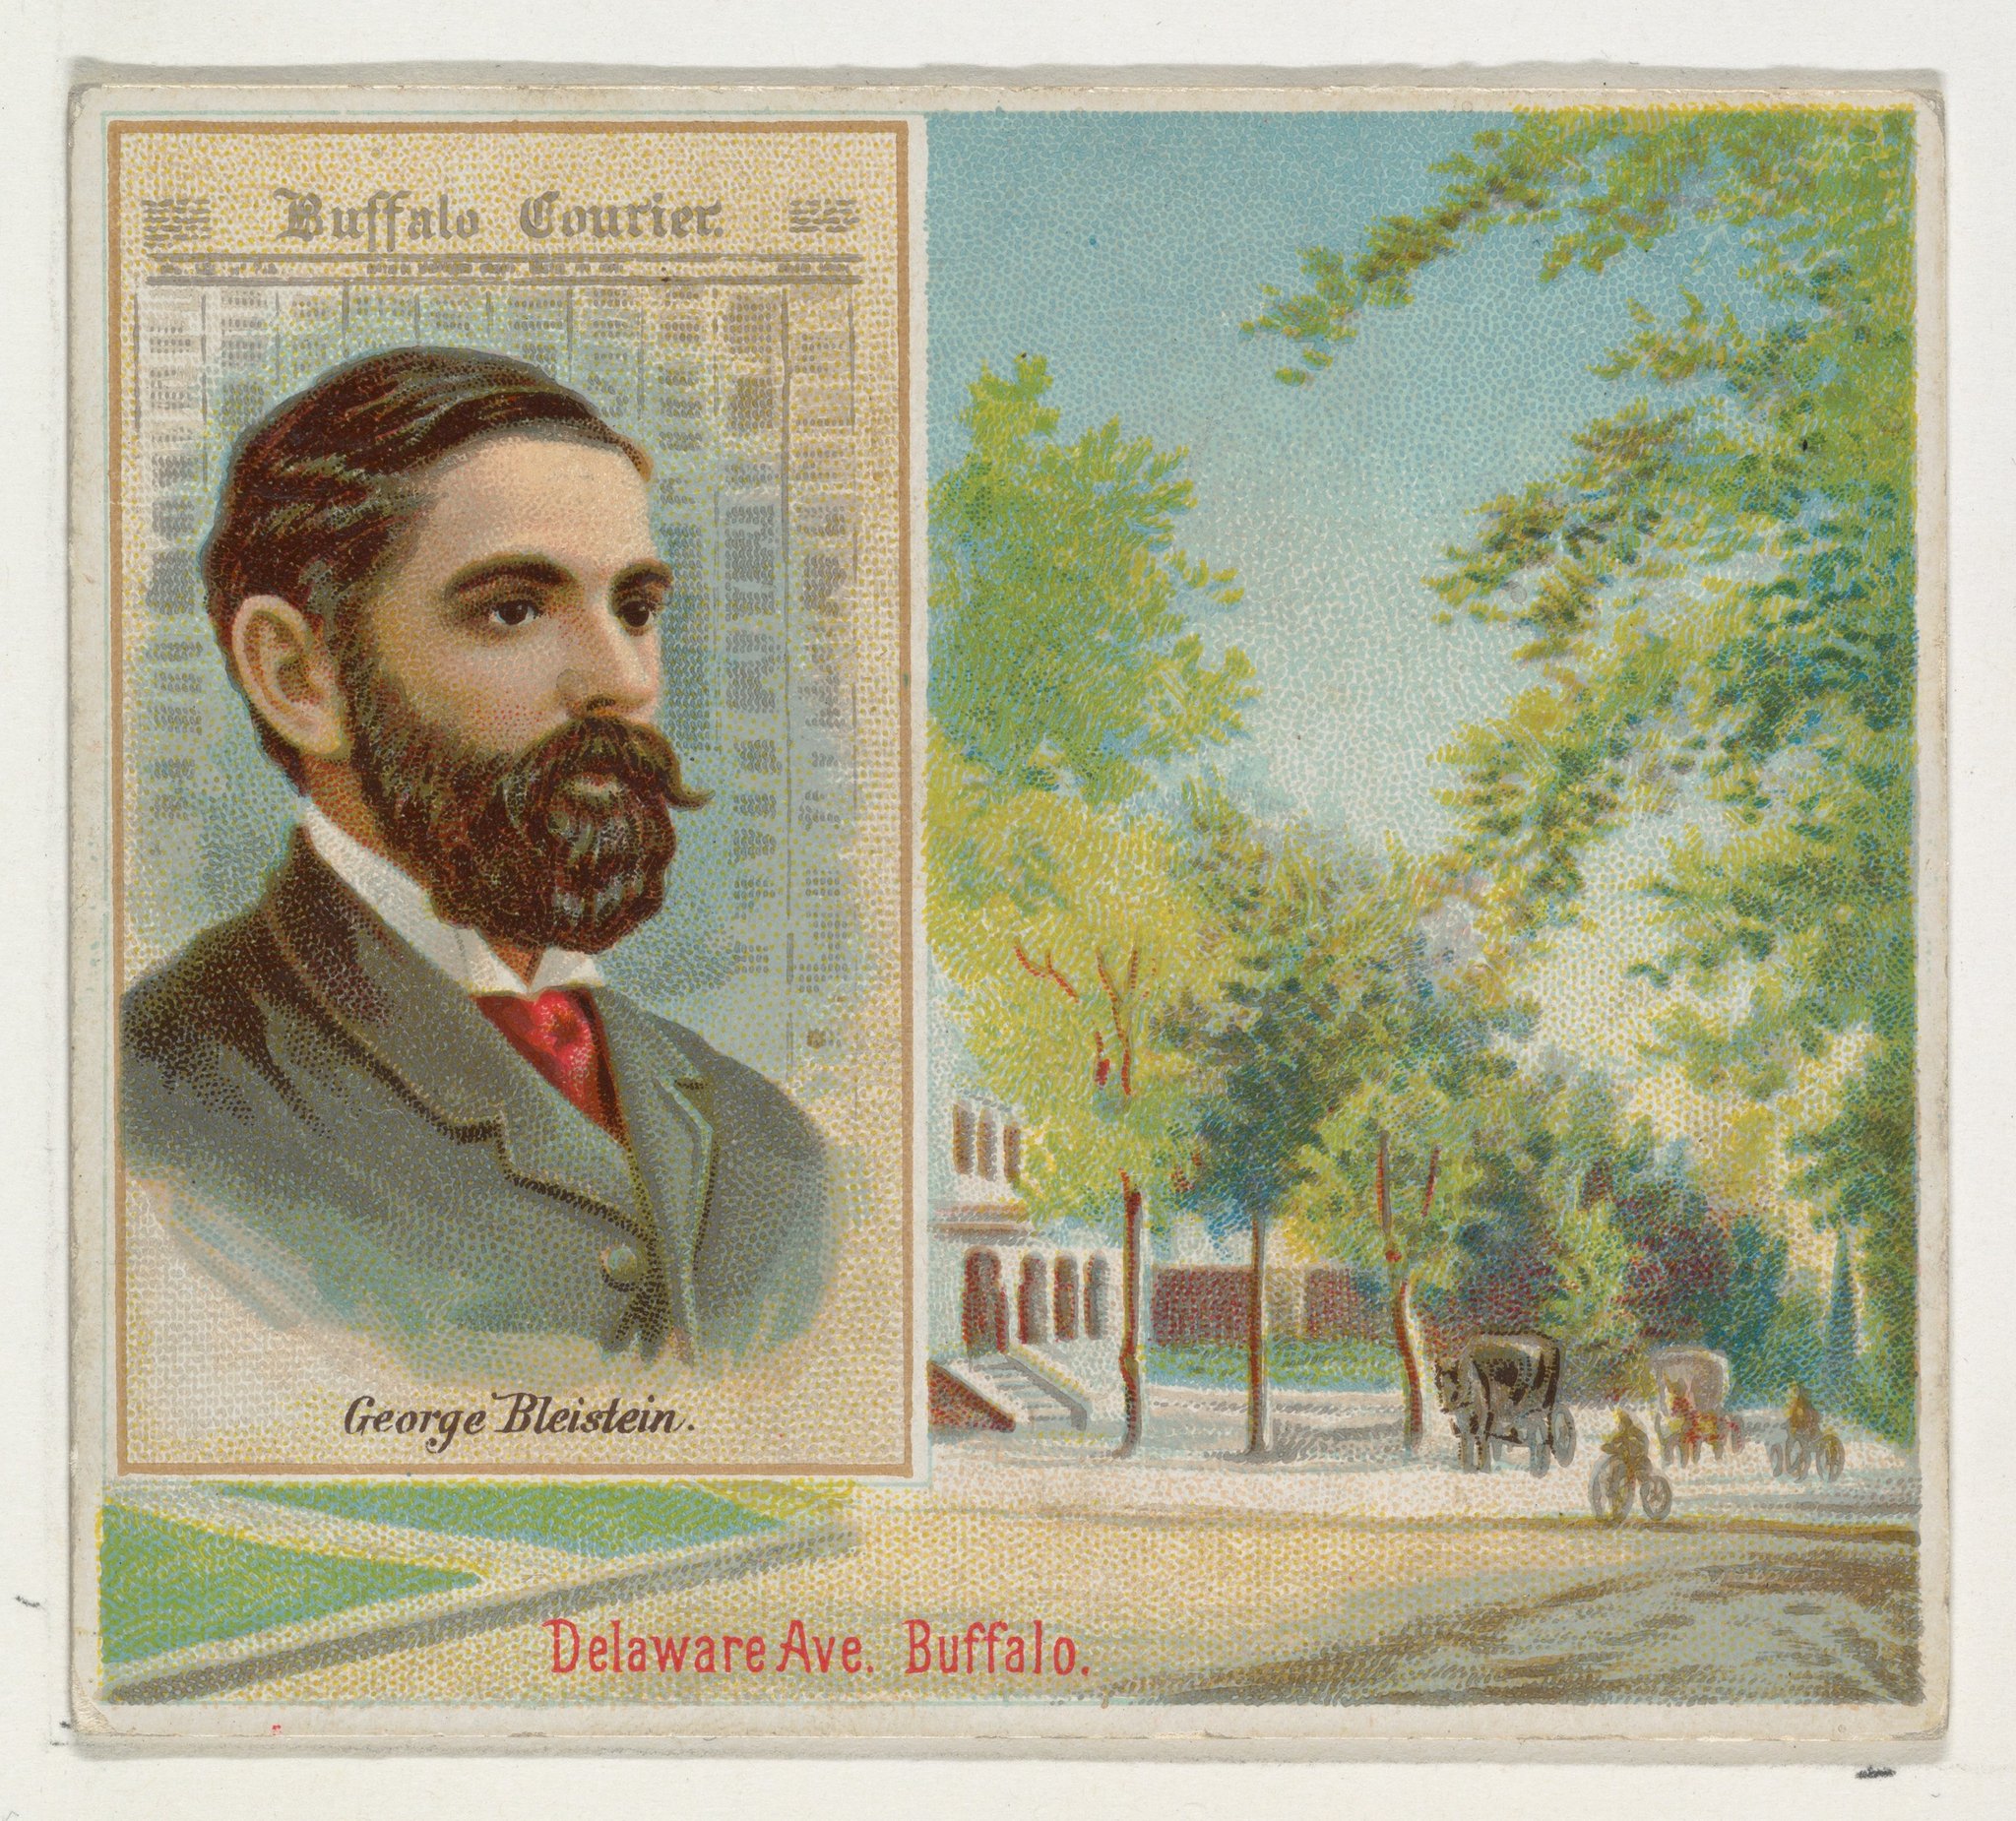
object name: print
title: George Bleistein, Buffalo Courier, from the American Editors series (N35) for Allen & Ginter Cigarettes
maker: allen & ginter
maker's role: publisher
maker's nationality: american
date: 1887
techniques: color lithograph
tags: men,profiles